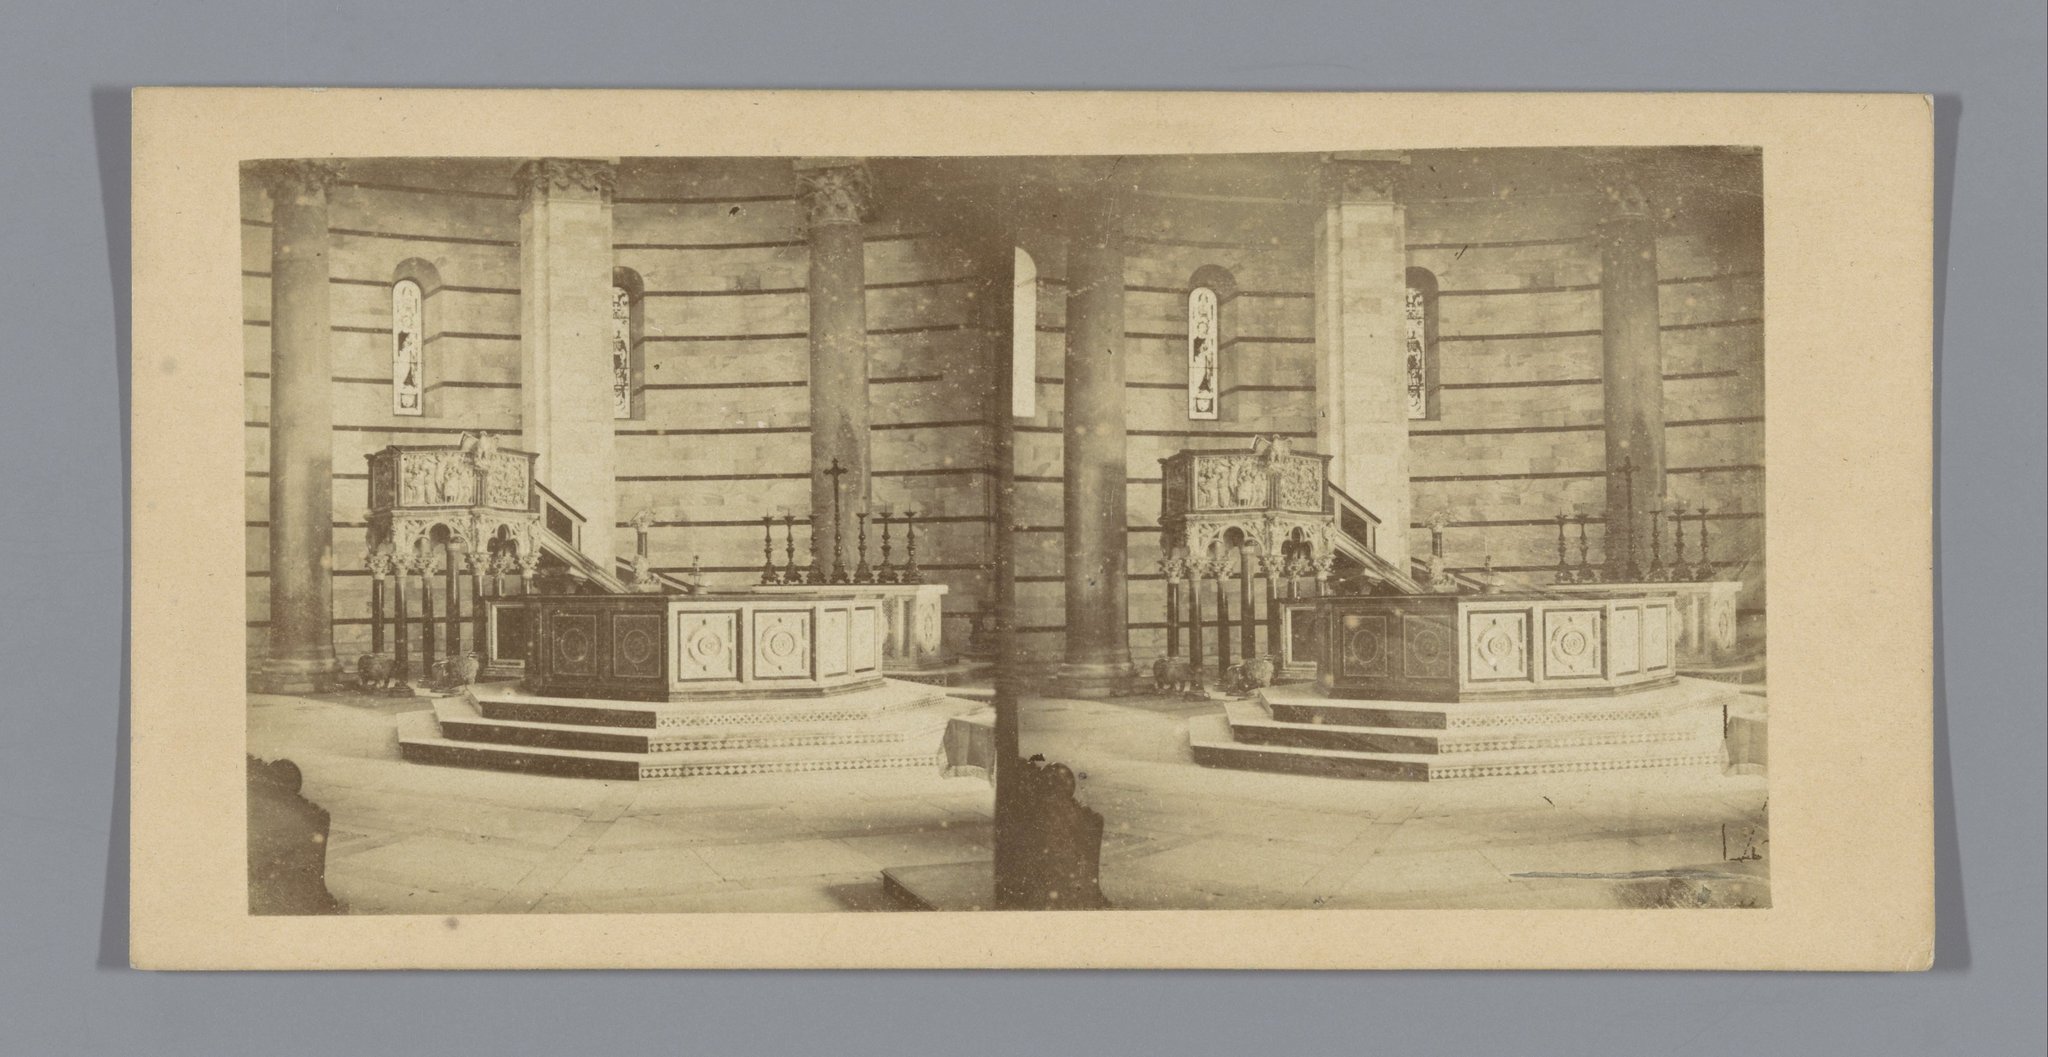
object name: stereograph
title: Doopvont en preekstoel in het Baptisterium te Pisa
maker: Anonymous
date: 1850-1880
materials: cardboard, photographic support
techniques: albumen print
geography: pisa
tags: pulpit, ambo, chancel, baptismal font, interior ~ representation of a building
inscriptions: inscription: ‘Pisa, Interieur du baptistere.’